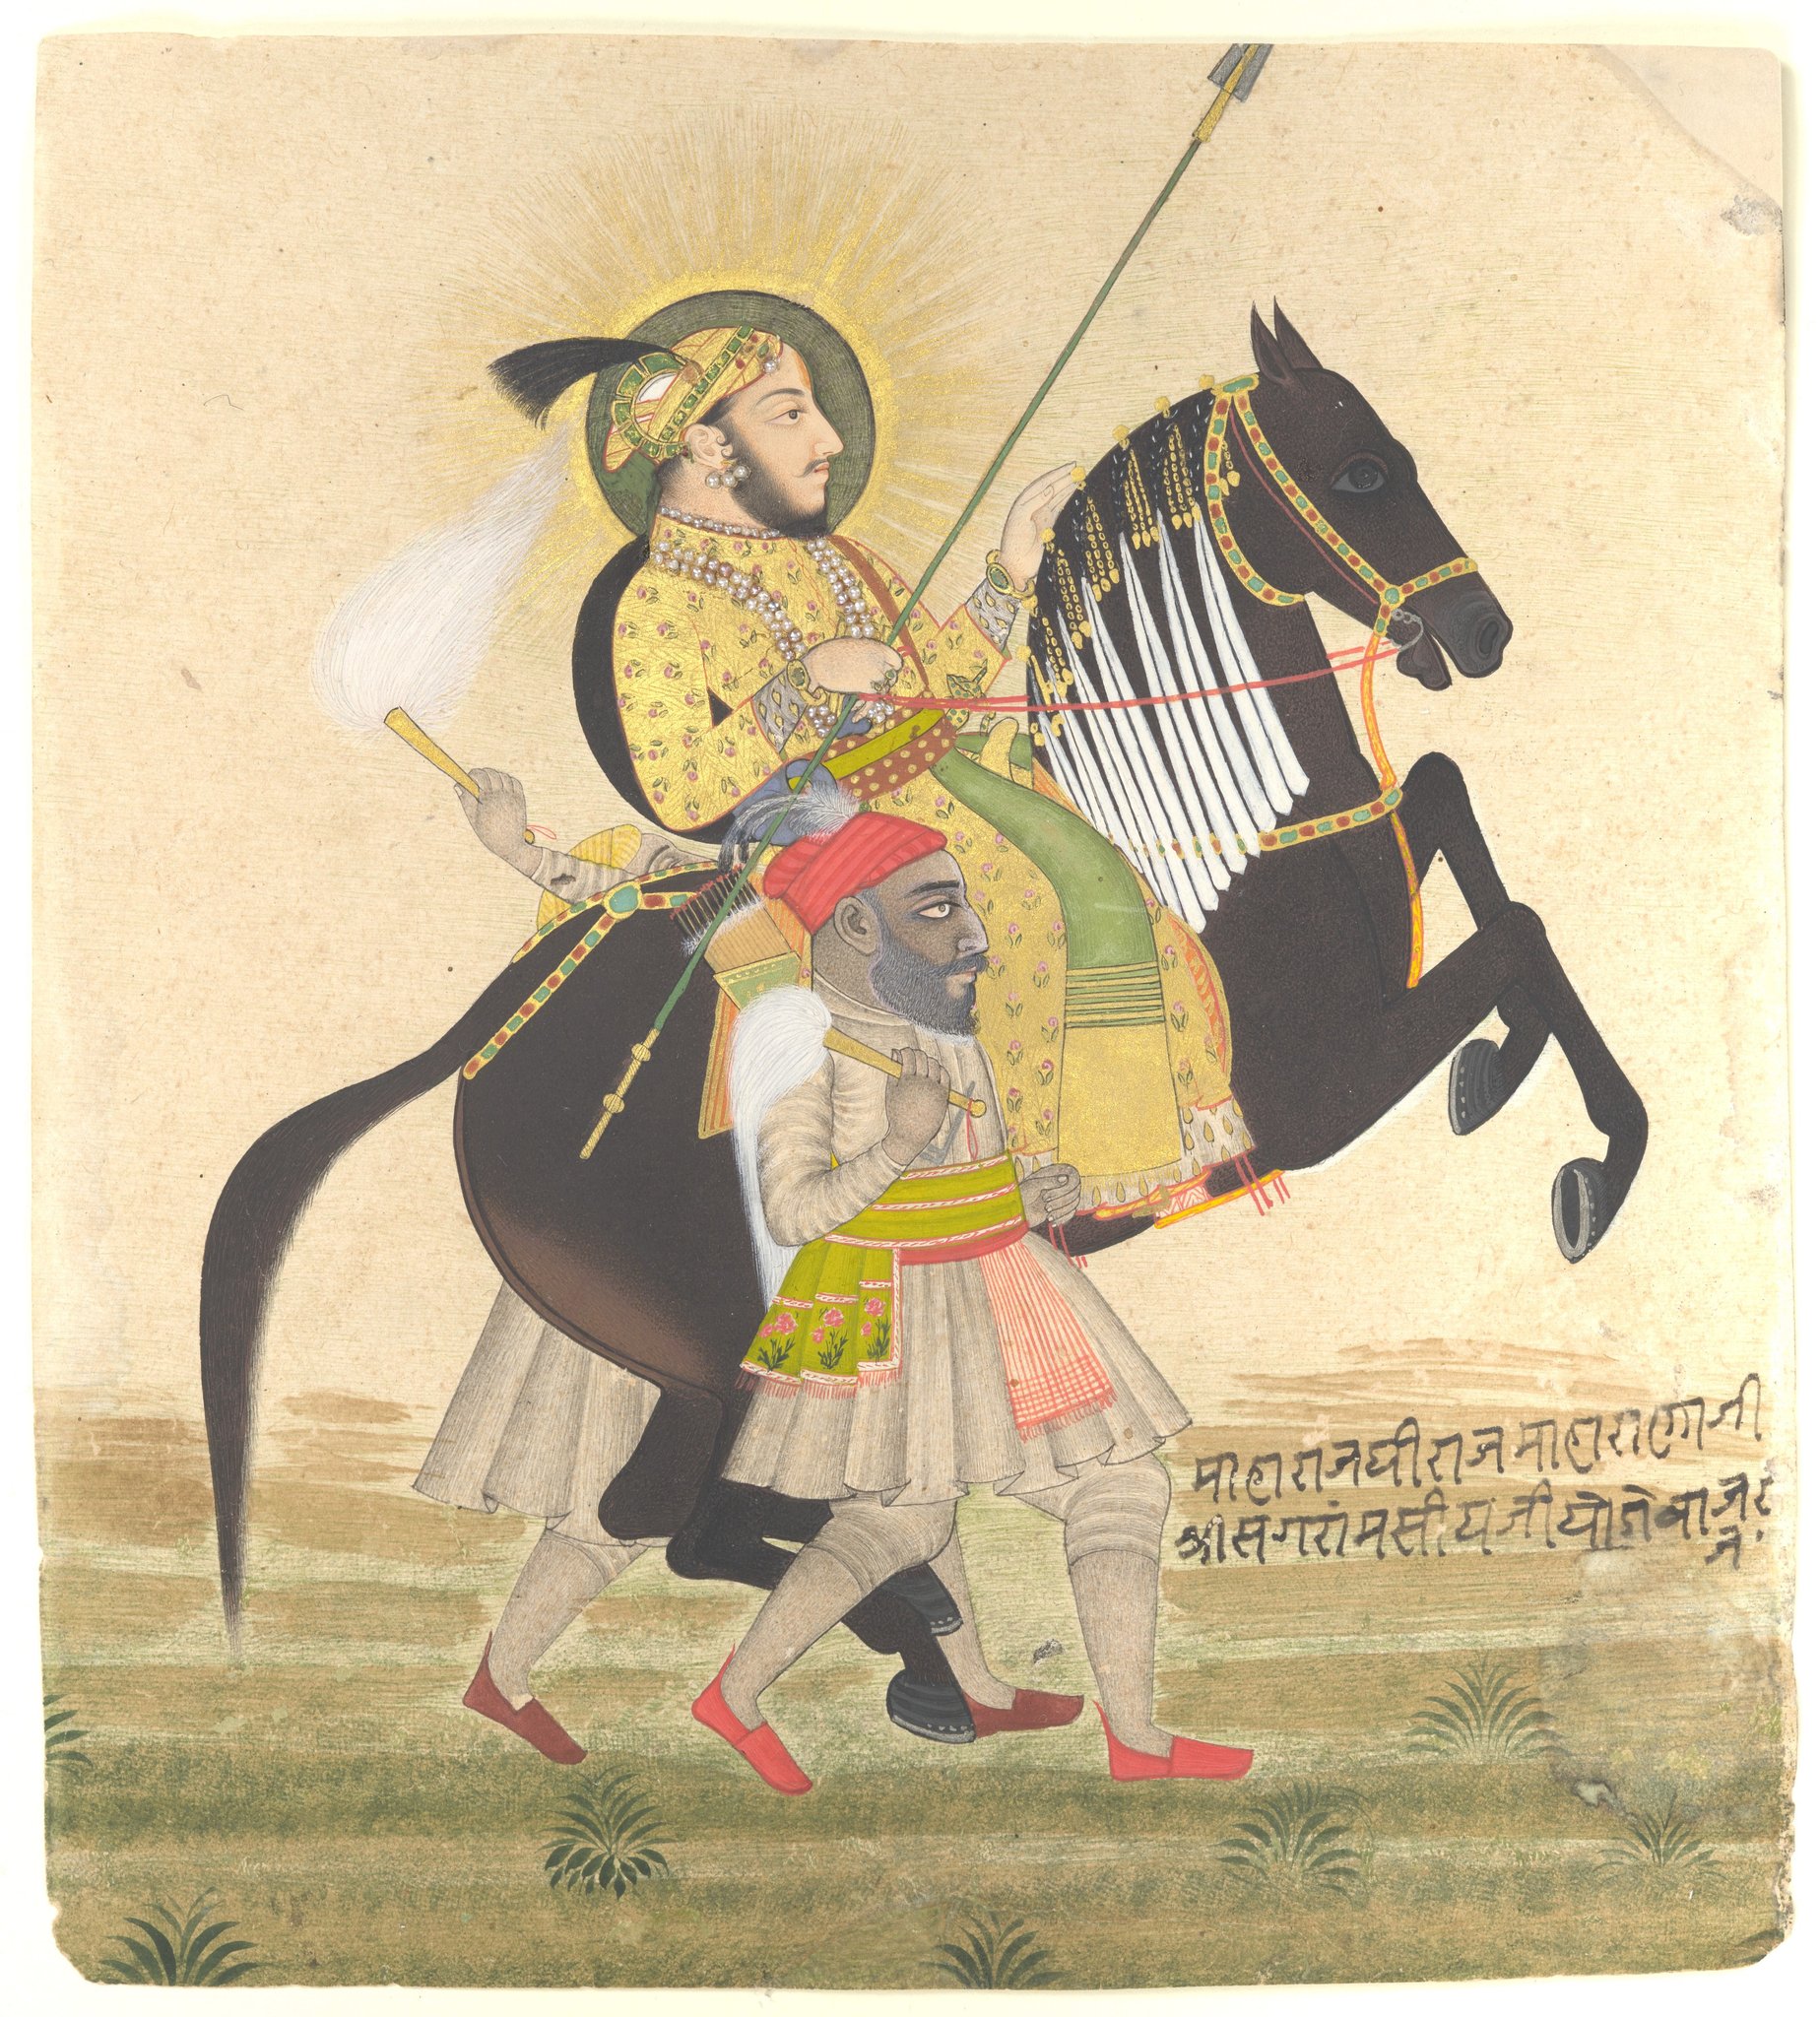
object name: painting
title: Maharana Sangram Singh Riding a Prize Stallion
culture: mewar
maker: stipple master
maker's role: artist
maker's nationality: indian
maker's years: 1680-1725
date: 1712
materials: gold, ink, paper, pearl, watercolor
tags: kings,men,horses